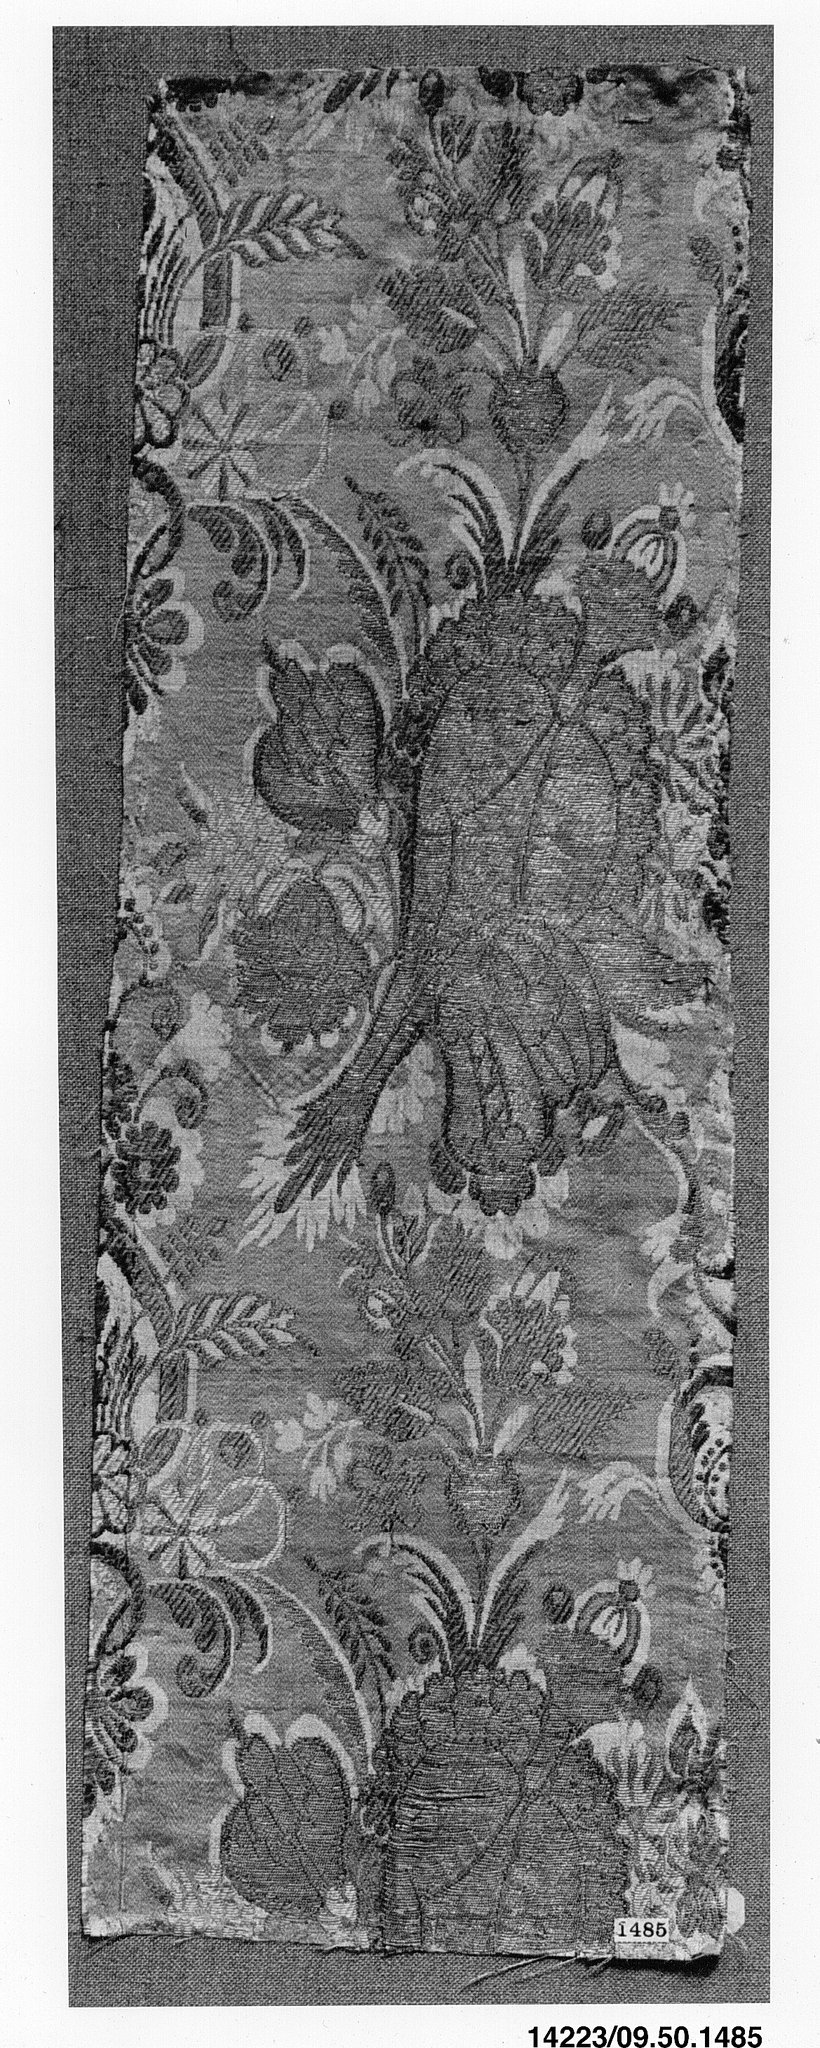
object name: piece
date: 1720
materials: metal thread, silk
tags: leaves